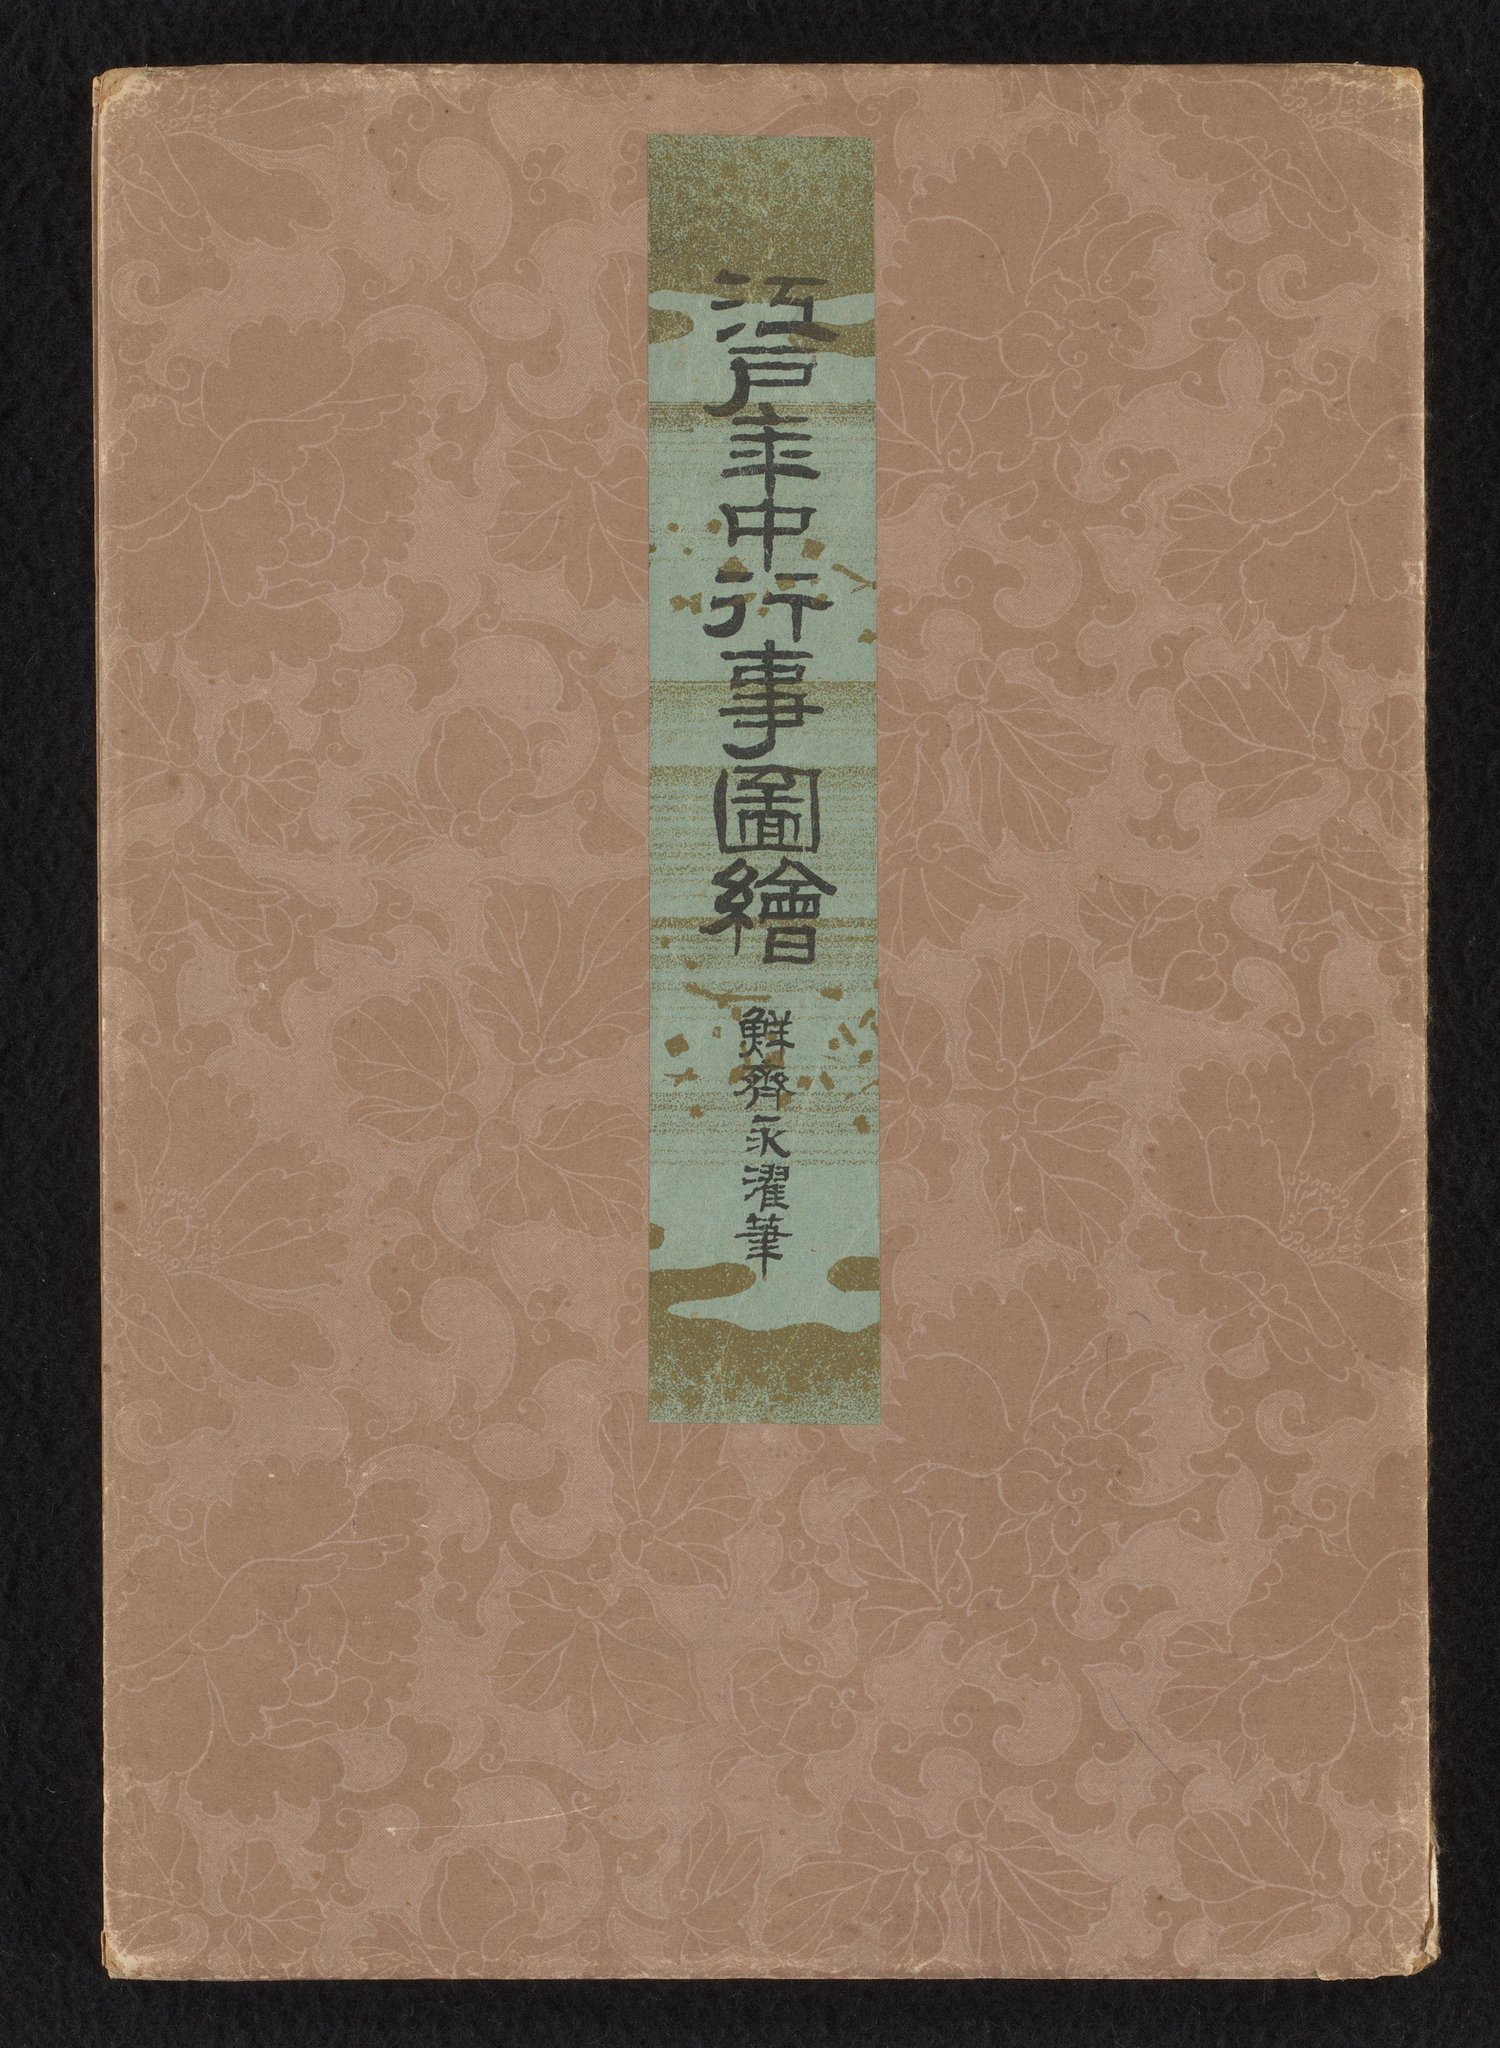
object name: book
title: Belangrijke evenementen van het jaar in Edo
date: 1893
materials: paper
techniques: lithograph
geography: japan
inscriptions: collector's mark: ‘Rijks-Ethnographisch Museum’, number: ‘1470 No. 3’